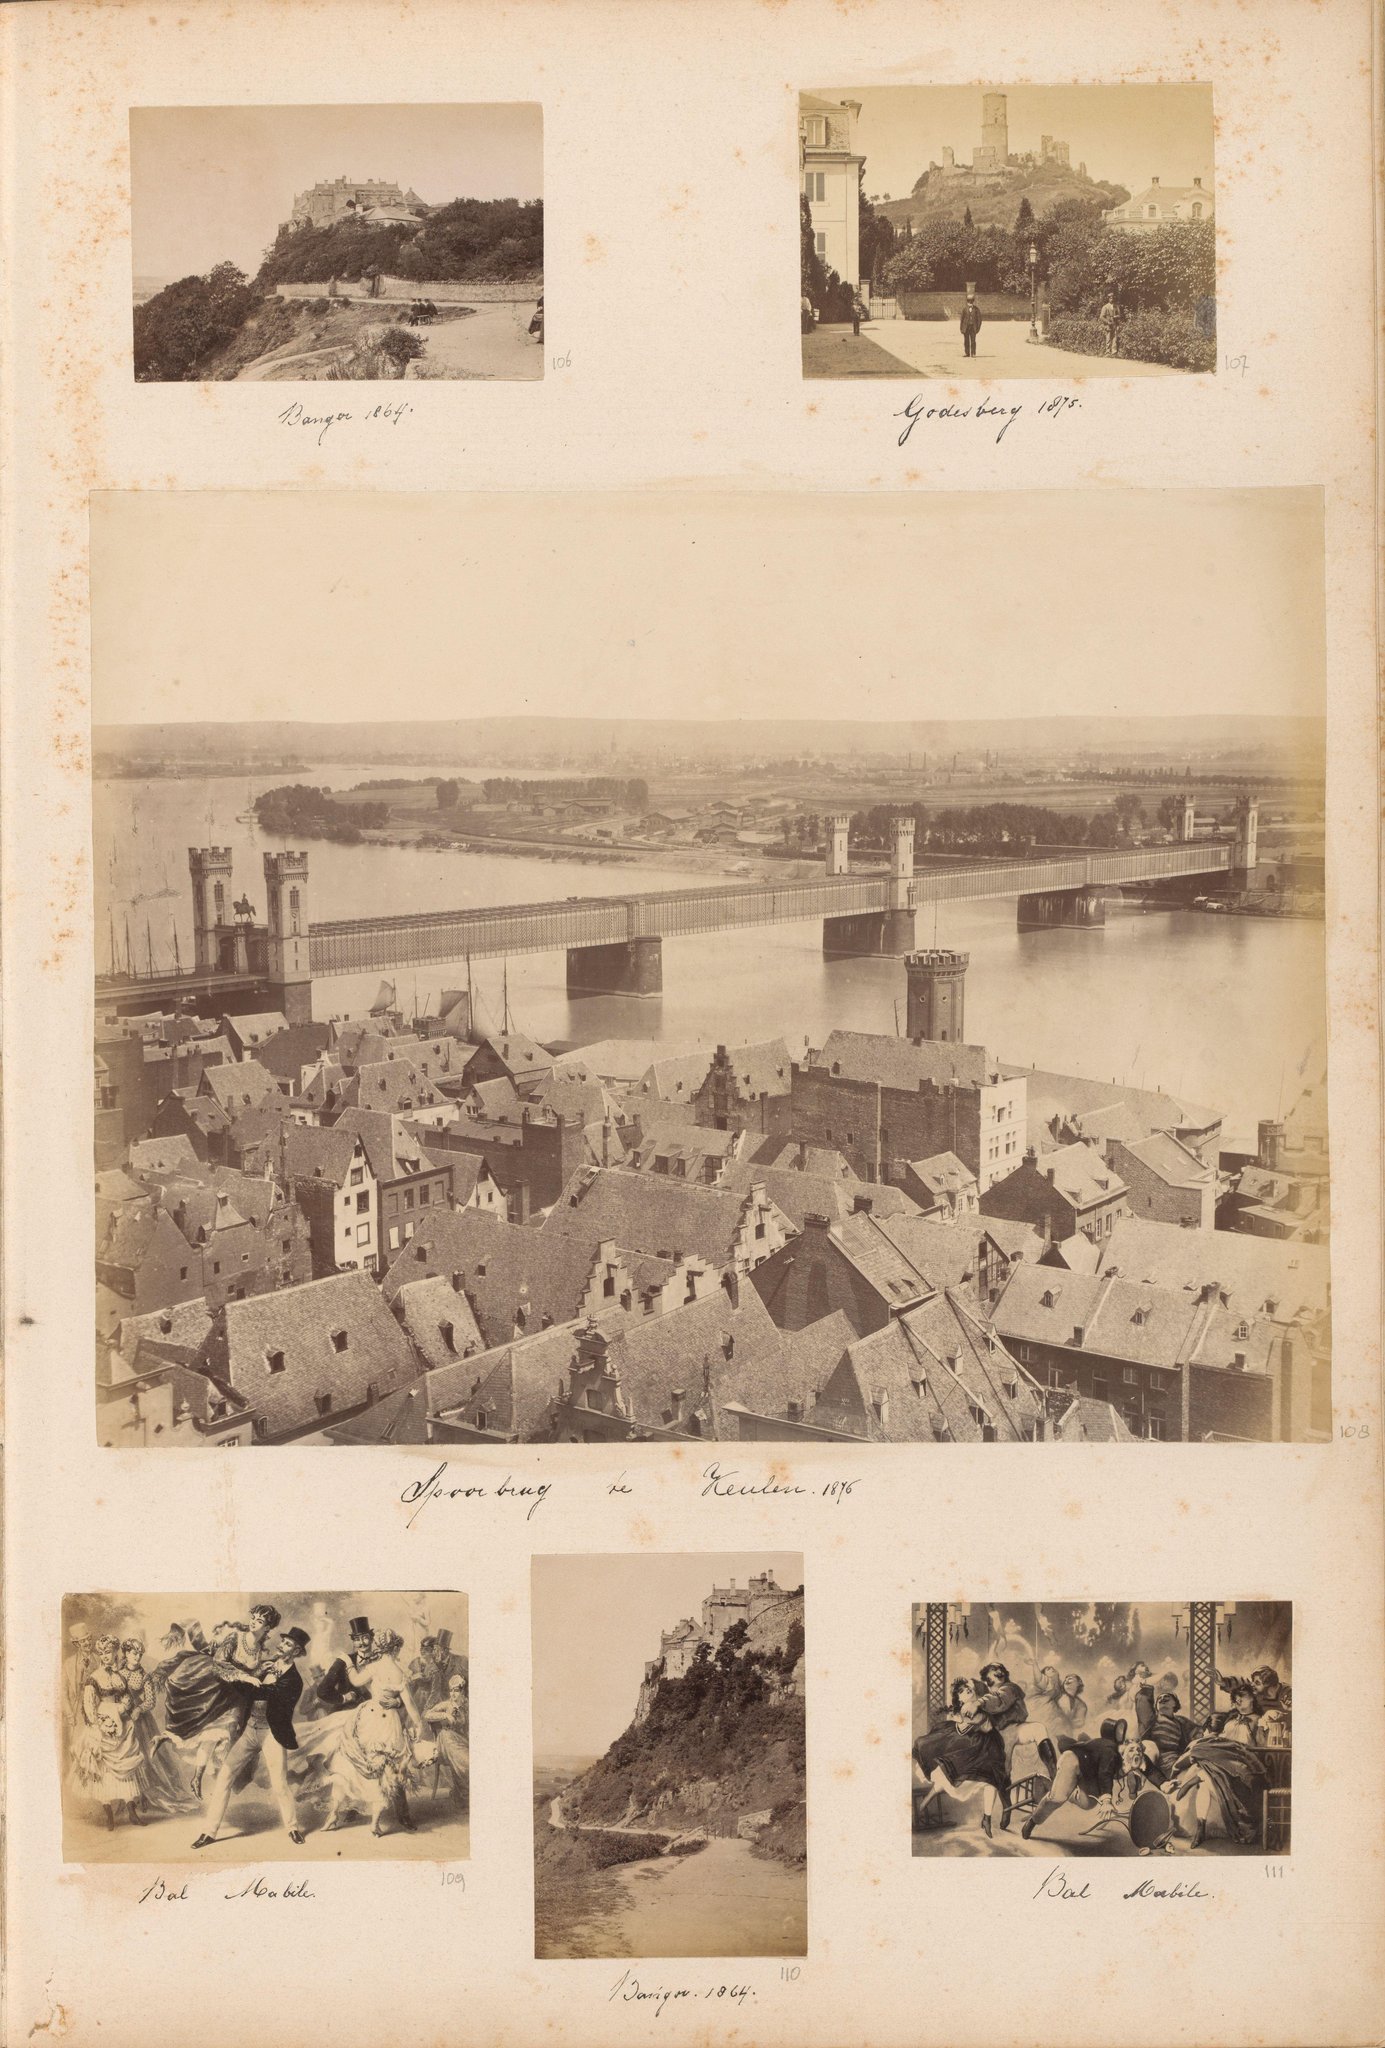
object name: album leaf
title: Gezicht op Godesberg met op de voorgrond vier personen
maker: Anonymous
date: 1875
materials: paper, photographic support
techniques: albumen print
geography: bad godesberg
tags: prospect of village, silhouette of village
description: Onderdeel van Fotoalbum van Robert Daniel Crommelin (1841-1907).